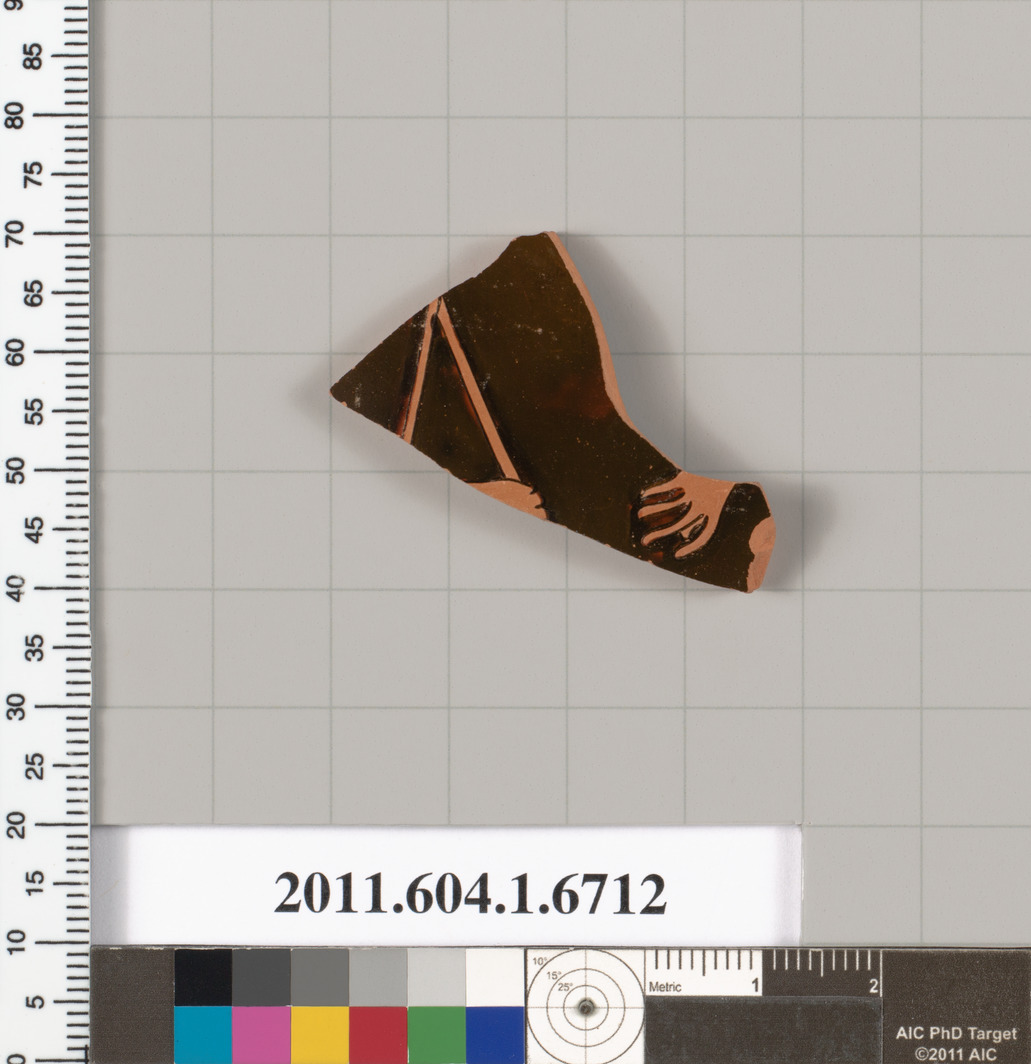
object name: kylix fragment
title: Terracotta fragment of a kylix (drinking cup)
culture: greek, attic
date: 490-470 BCE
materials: terracotta